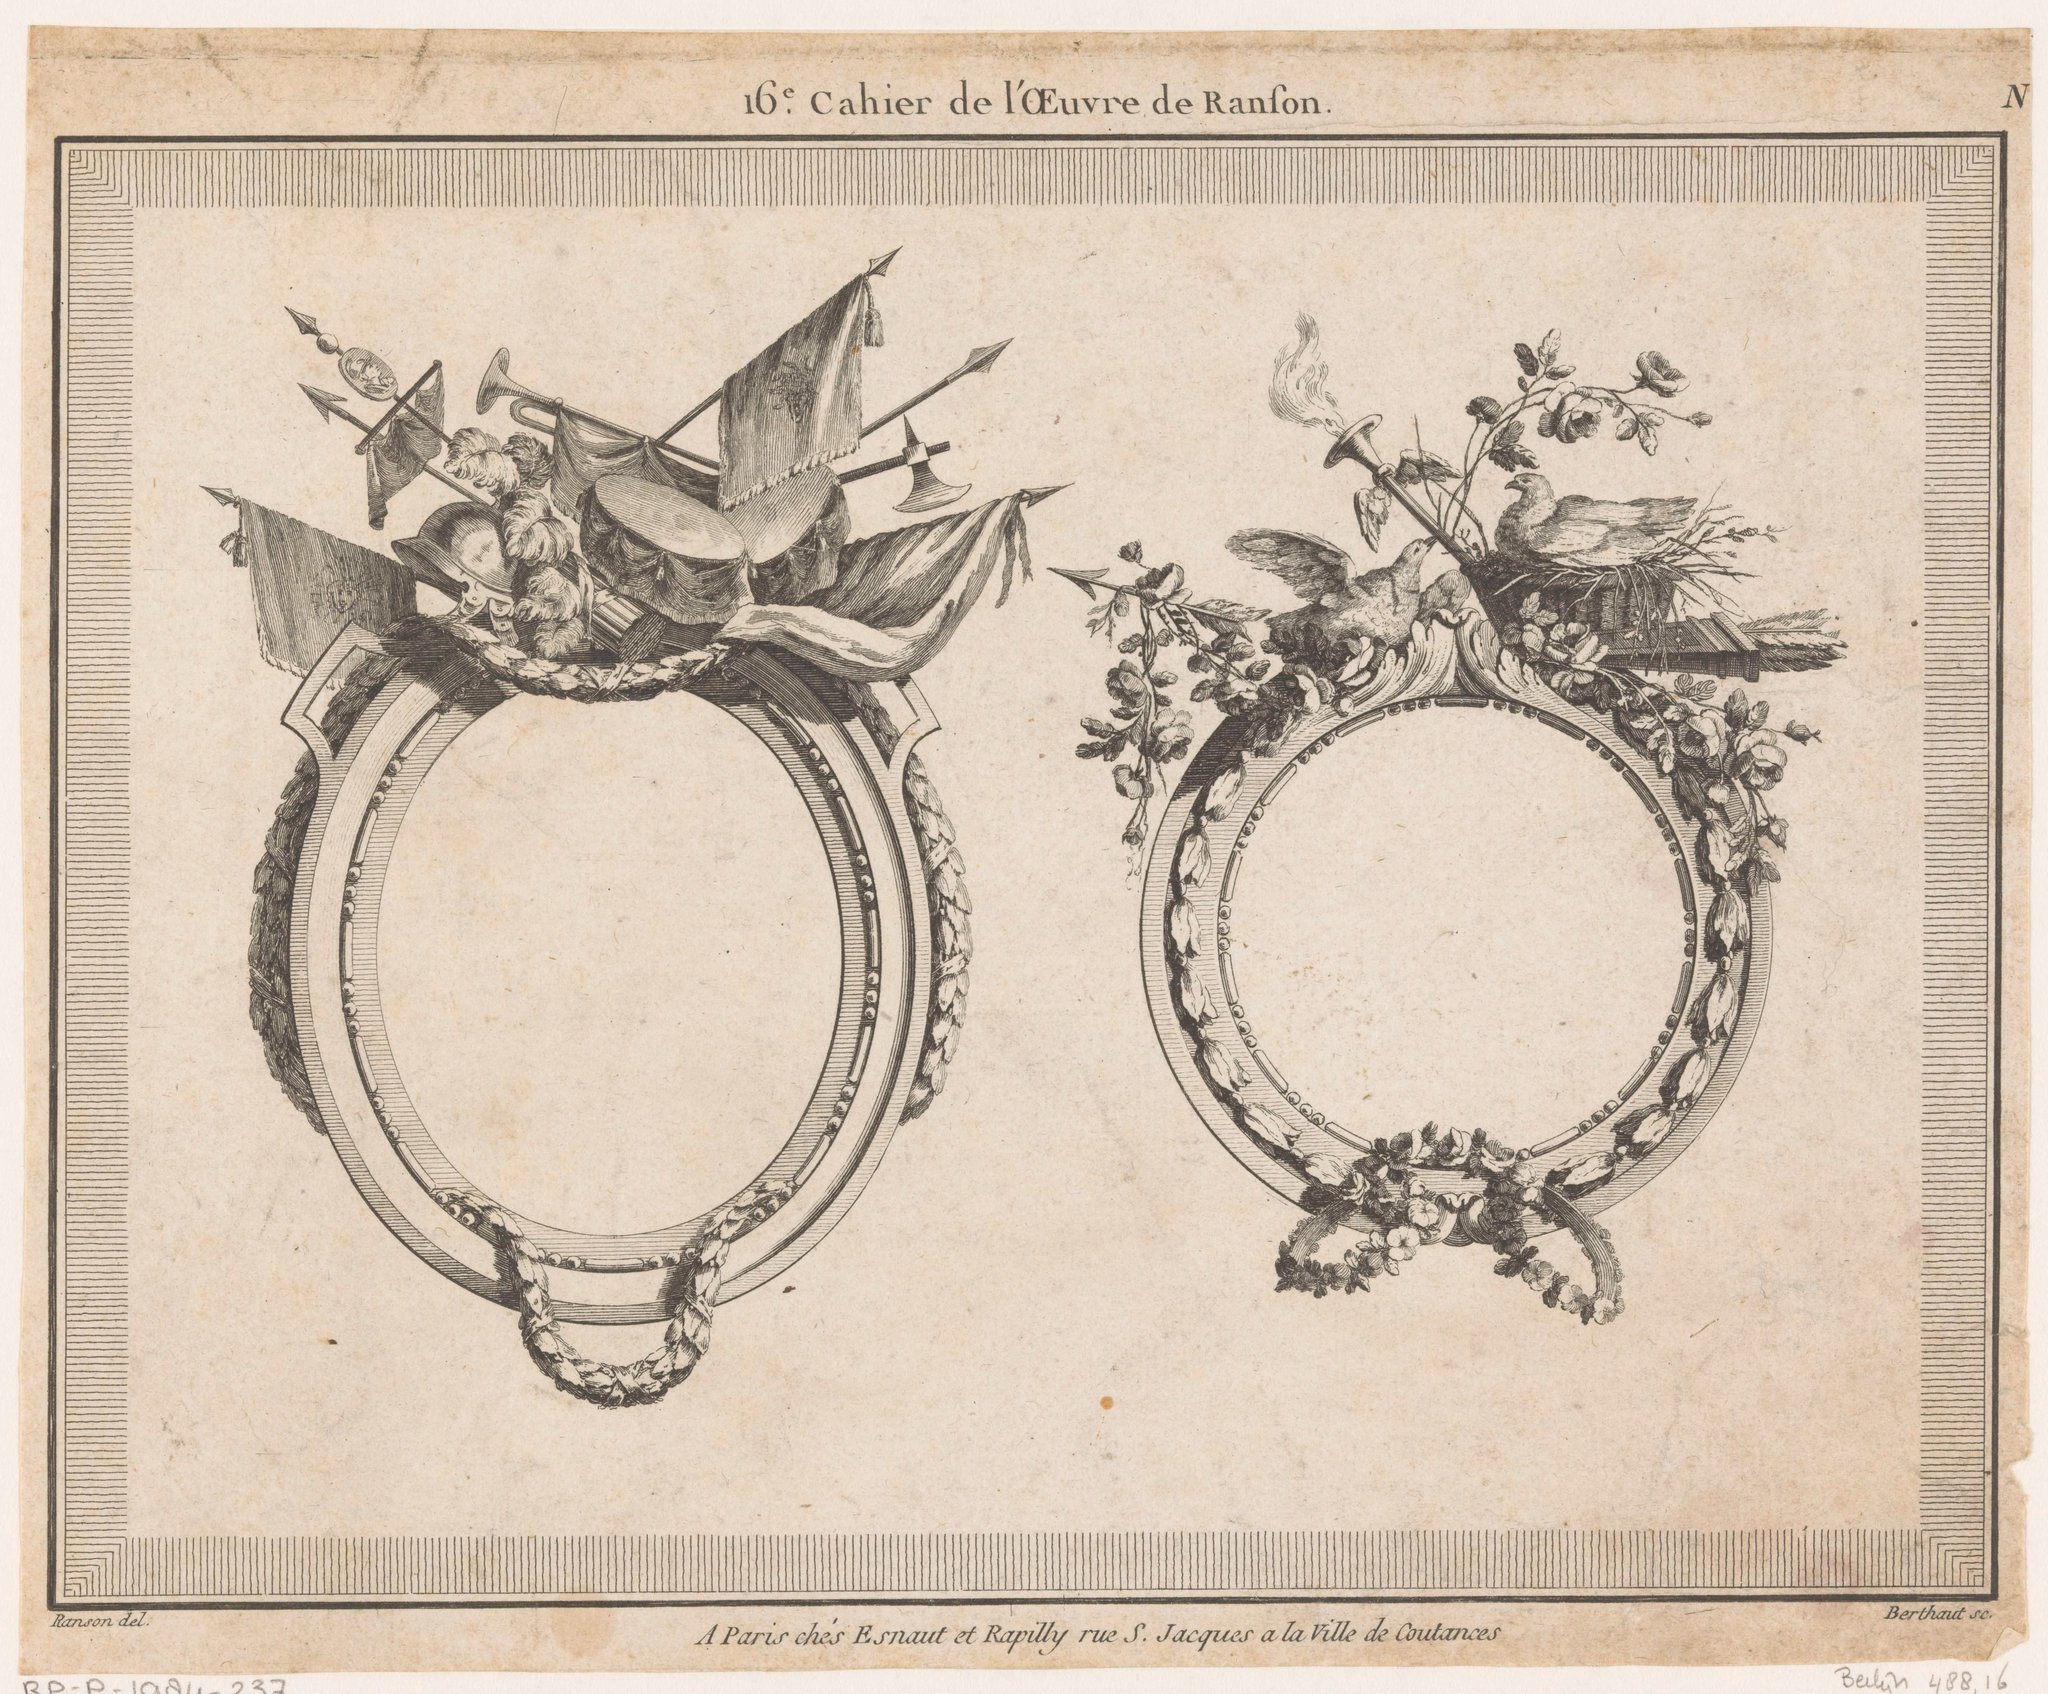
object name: titelprent, frontispice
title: 16e Cahier de l'Oeuvre de Ranson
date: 1778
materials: paper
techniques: etching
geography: paris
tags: birds, ornament ~ medallion, weapons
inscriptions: collector's mark: Lugt 2228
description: Links een ovaal medaillon met vlaggen, muziekinstrumenten en wapens. Rechts een rond medaillons met vogels, fakkel en pijlenkoker.